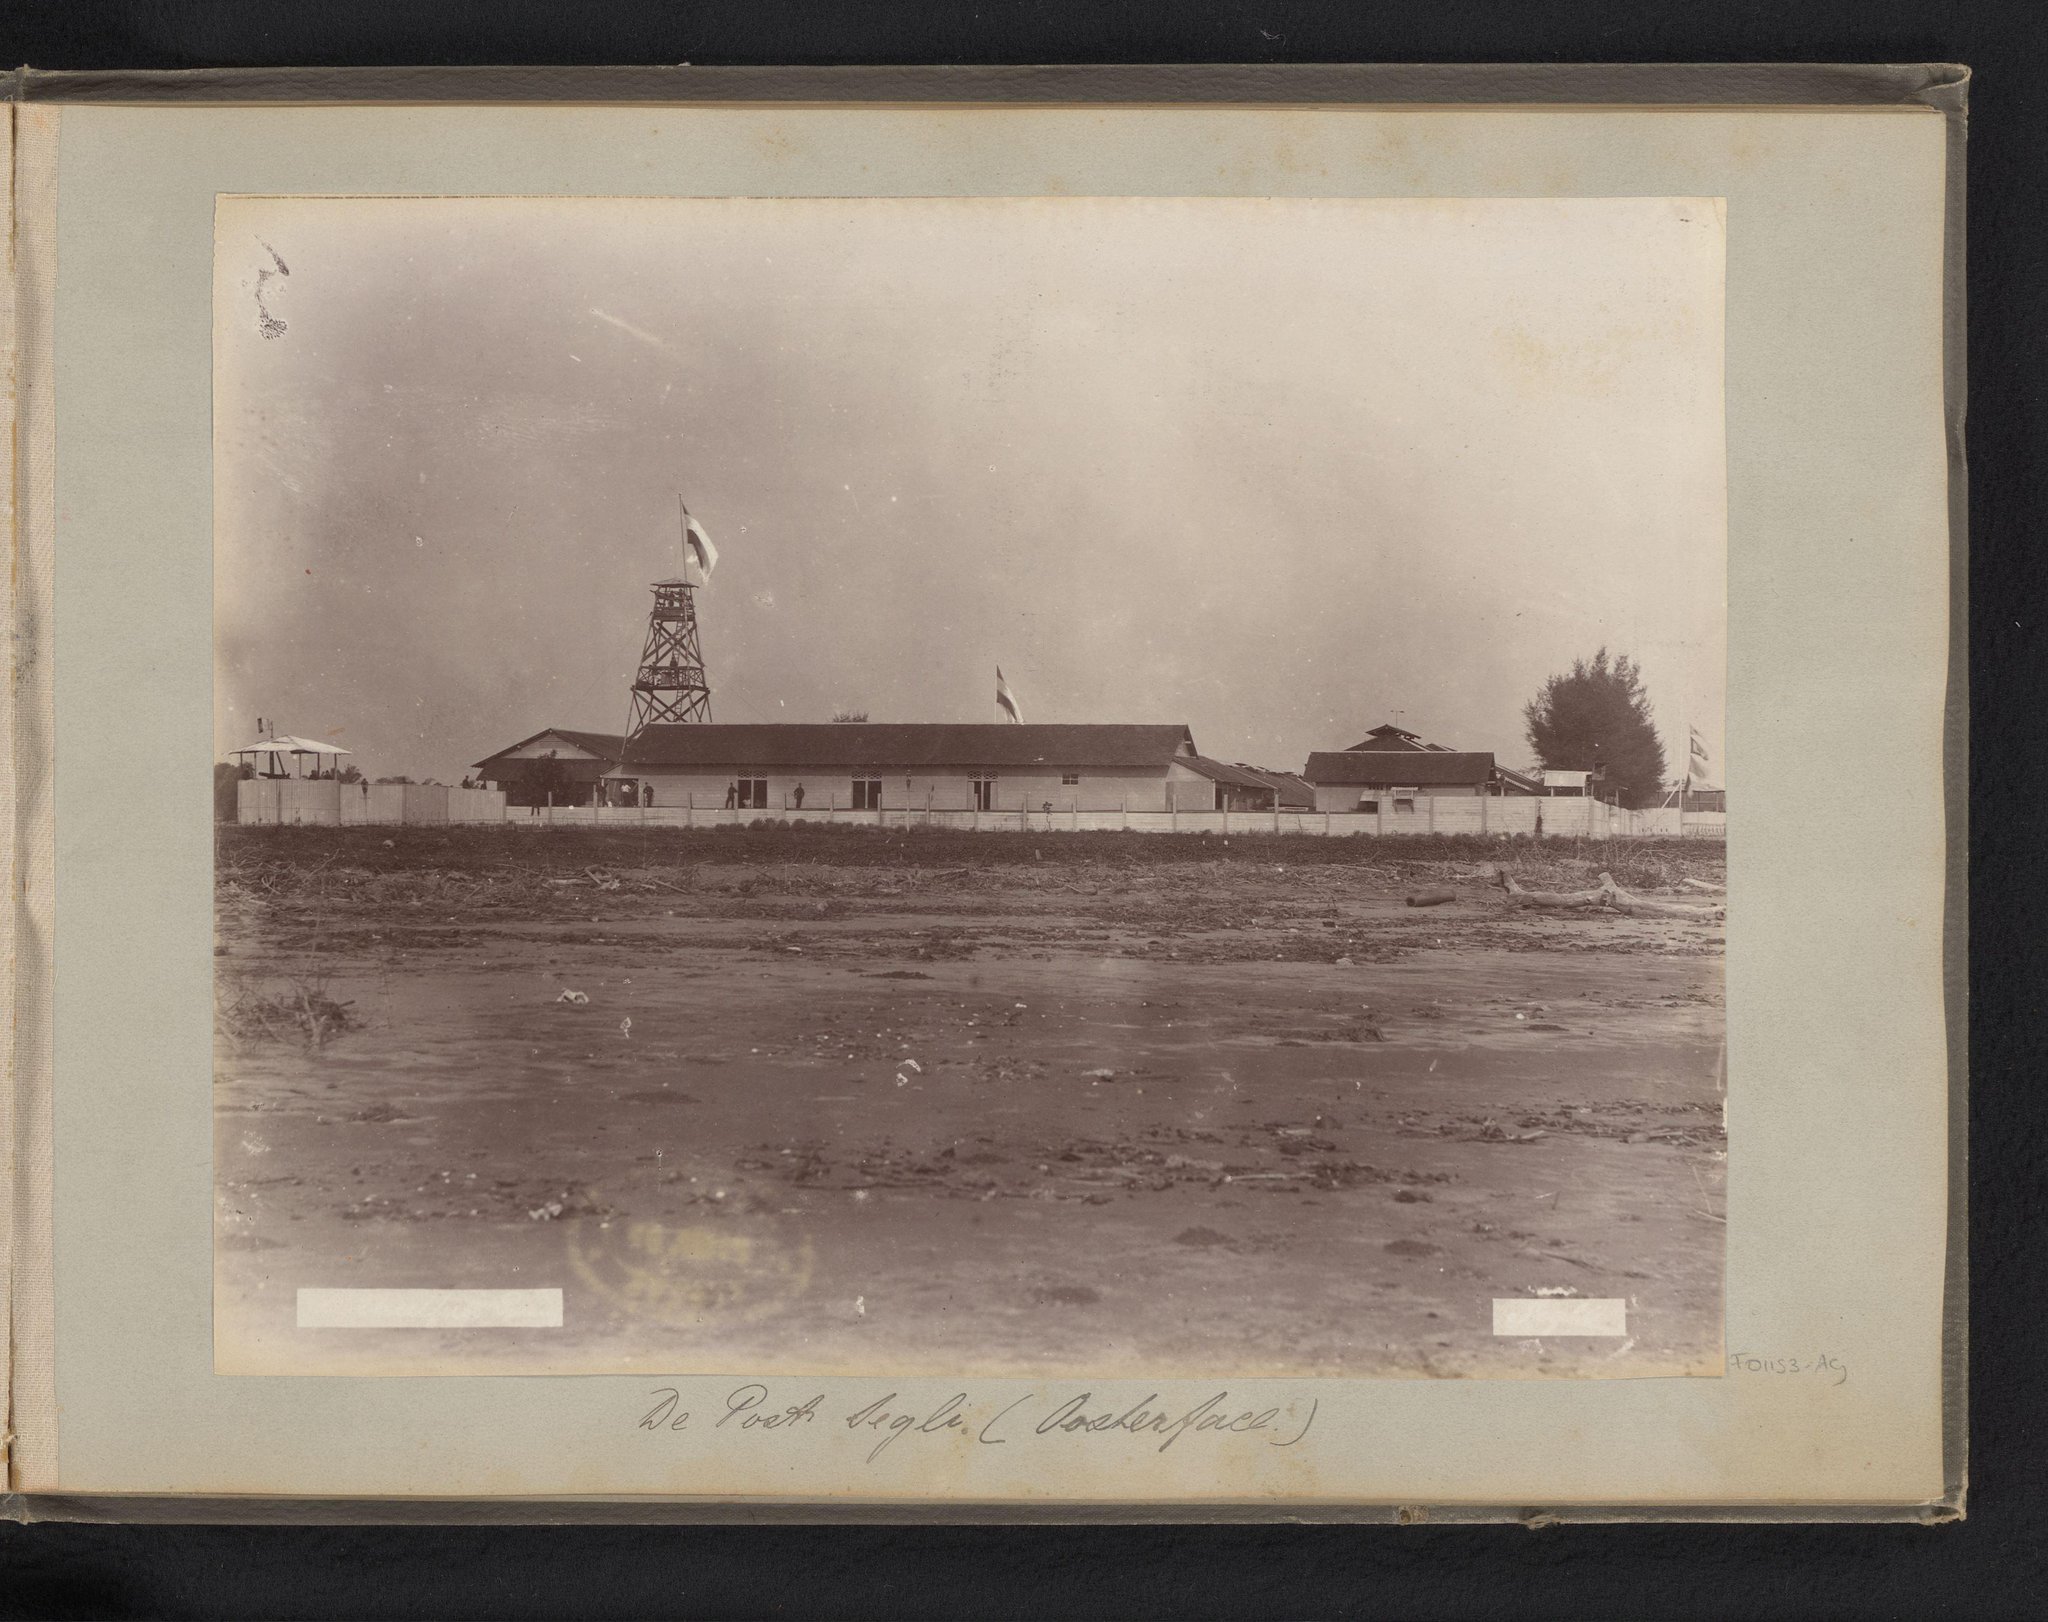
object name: album leaf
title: De Poeti Seglo (Oosterface)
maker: a. kaulfuss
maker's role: fotograaf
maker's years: 1861-1909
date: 1891-1894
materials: photographic support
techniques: albumen print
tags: shelter ~ military service